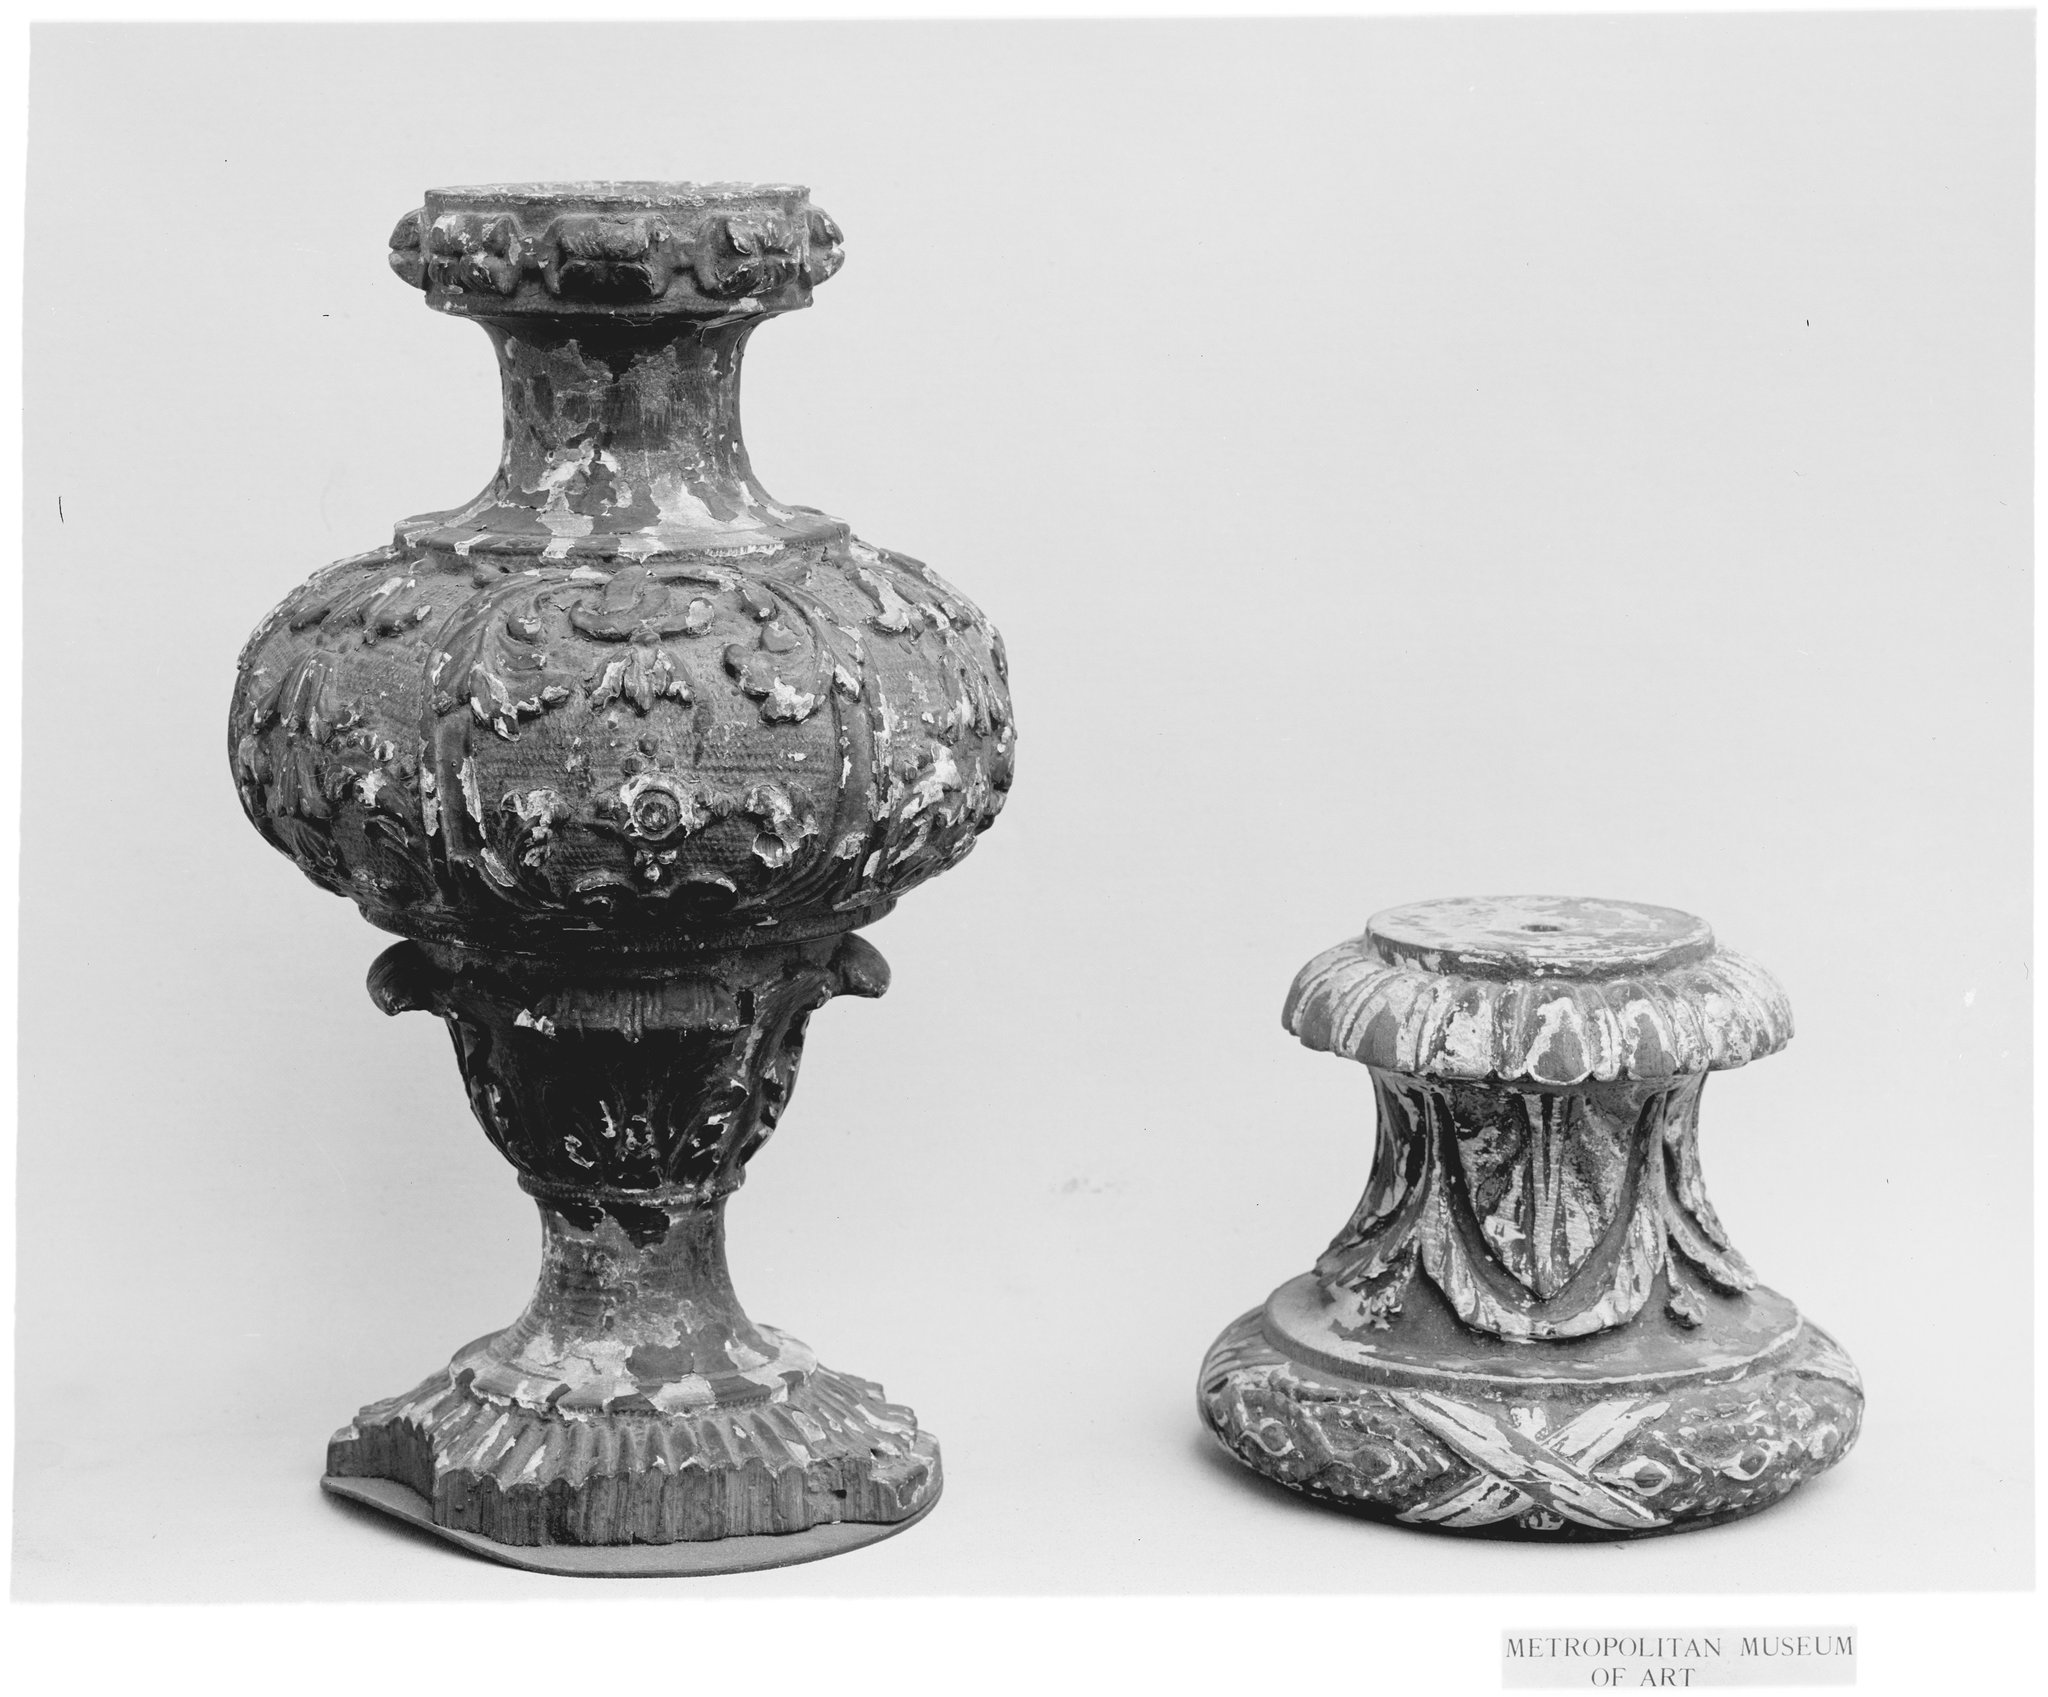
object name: plinth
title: Plinth detail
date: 1701-1800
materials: gilt, wood